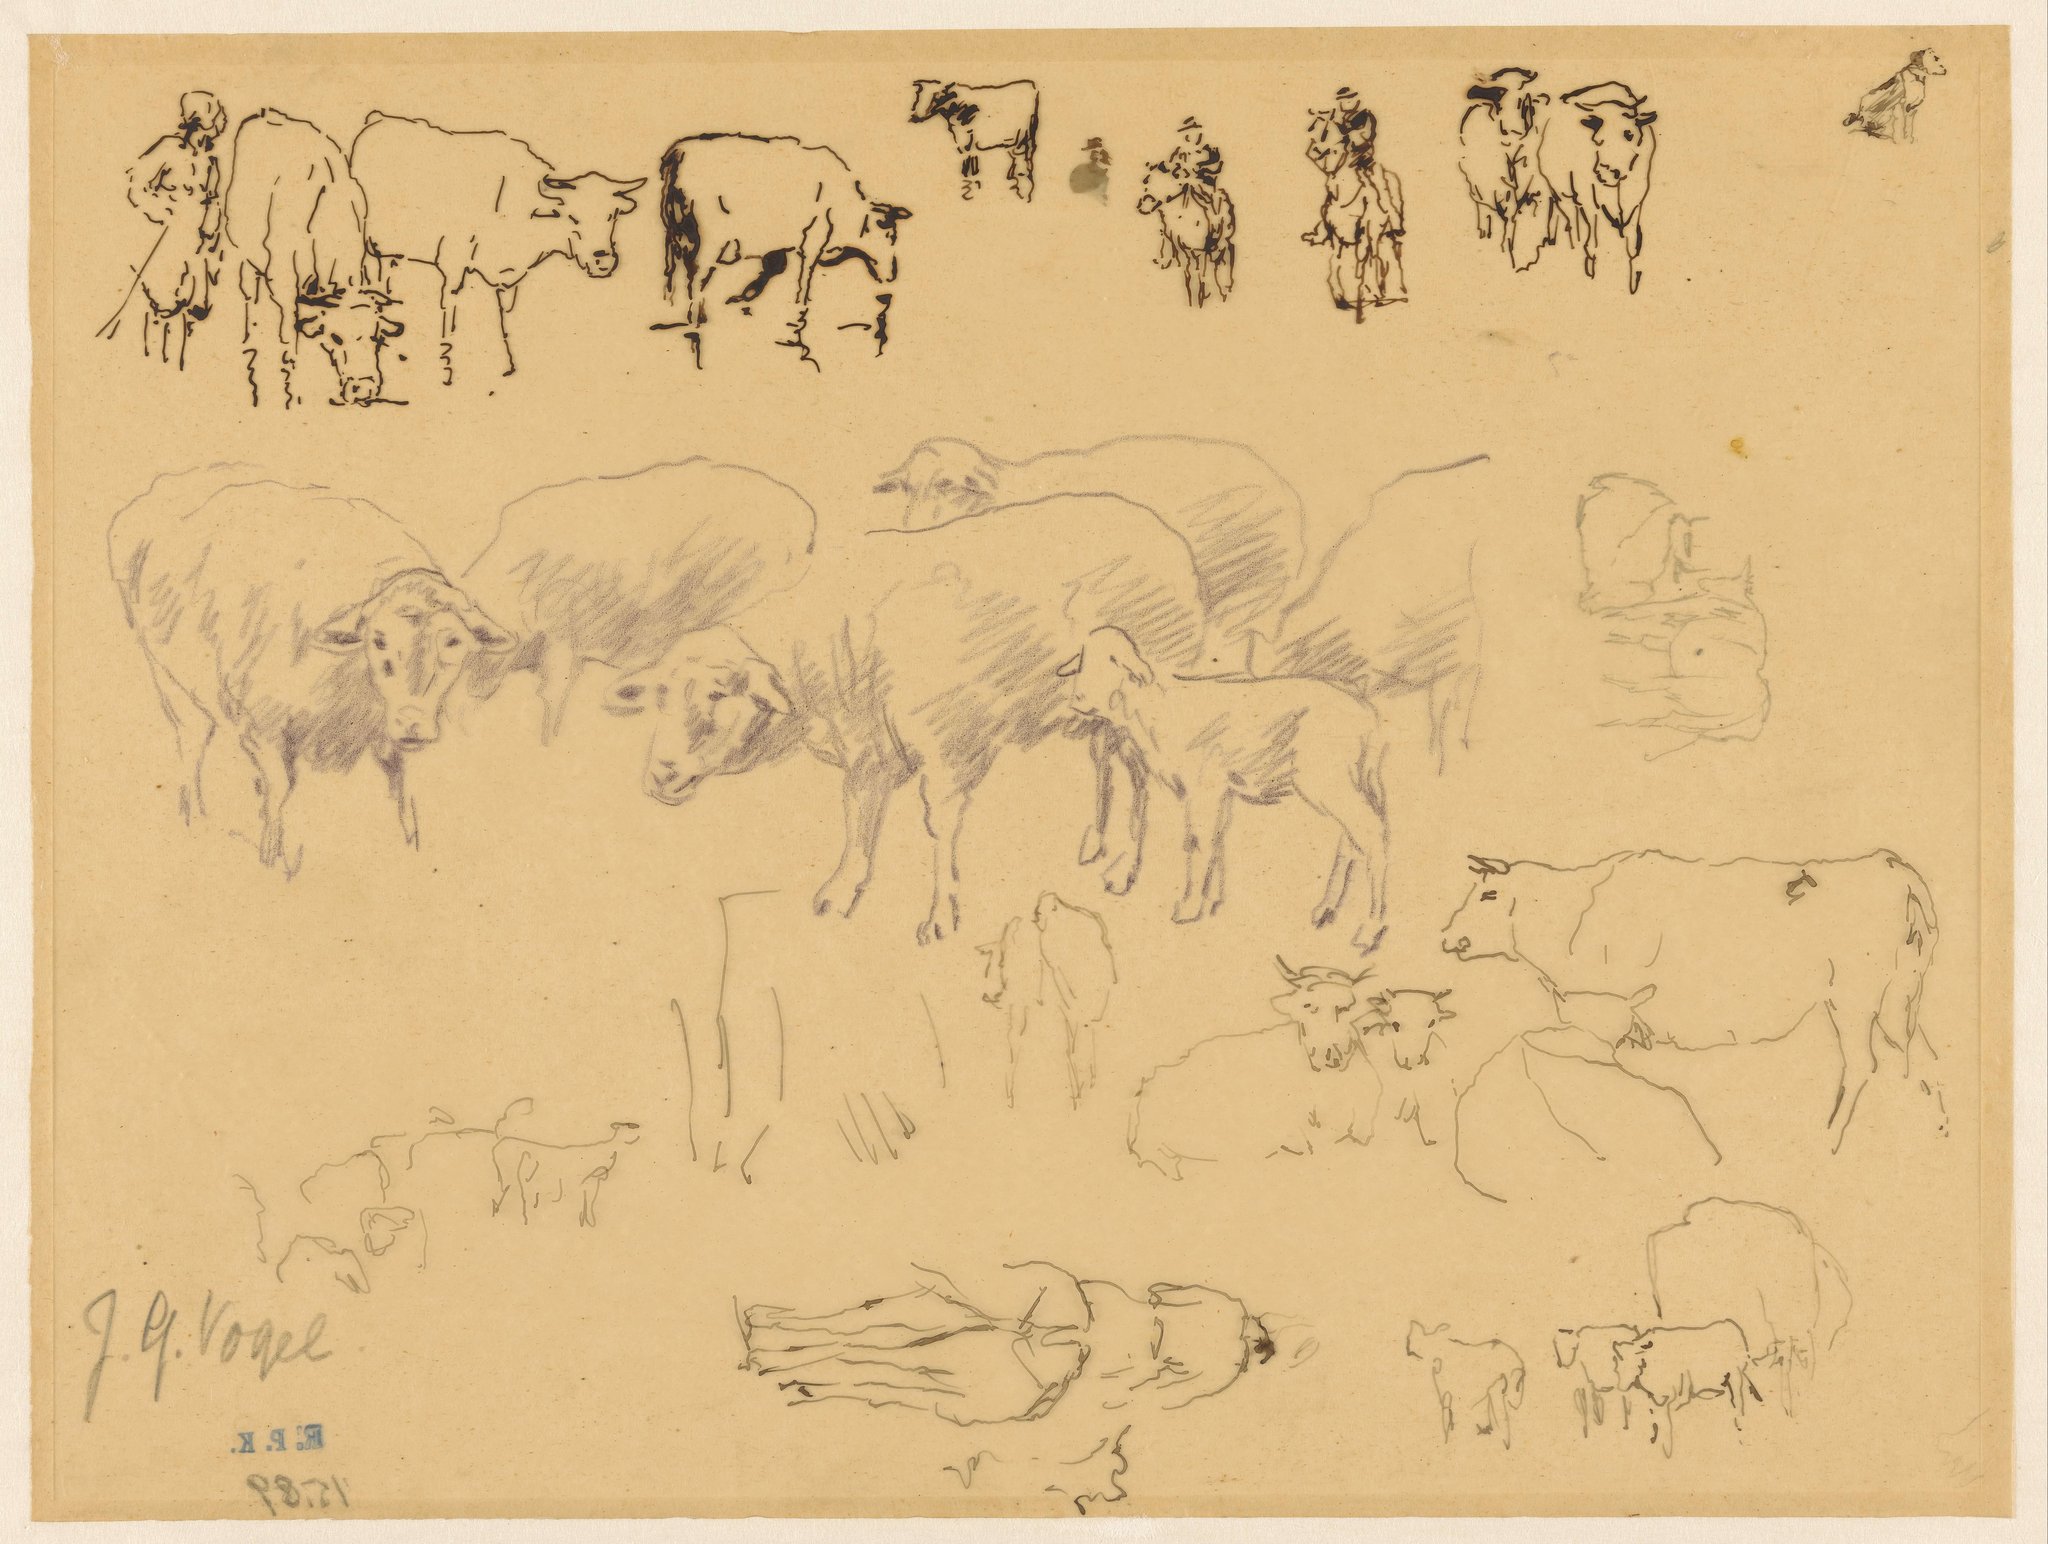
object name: drawing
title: Studieblad met koeien en schapen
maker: johannes gijsbert vogel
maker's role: draughtsman, painter, print maker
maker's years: 1828-1915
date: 1838-1915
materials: ink, pencil, paper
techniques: pen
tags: sheep, bovine cattle